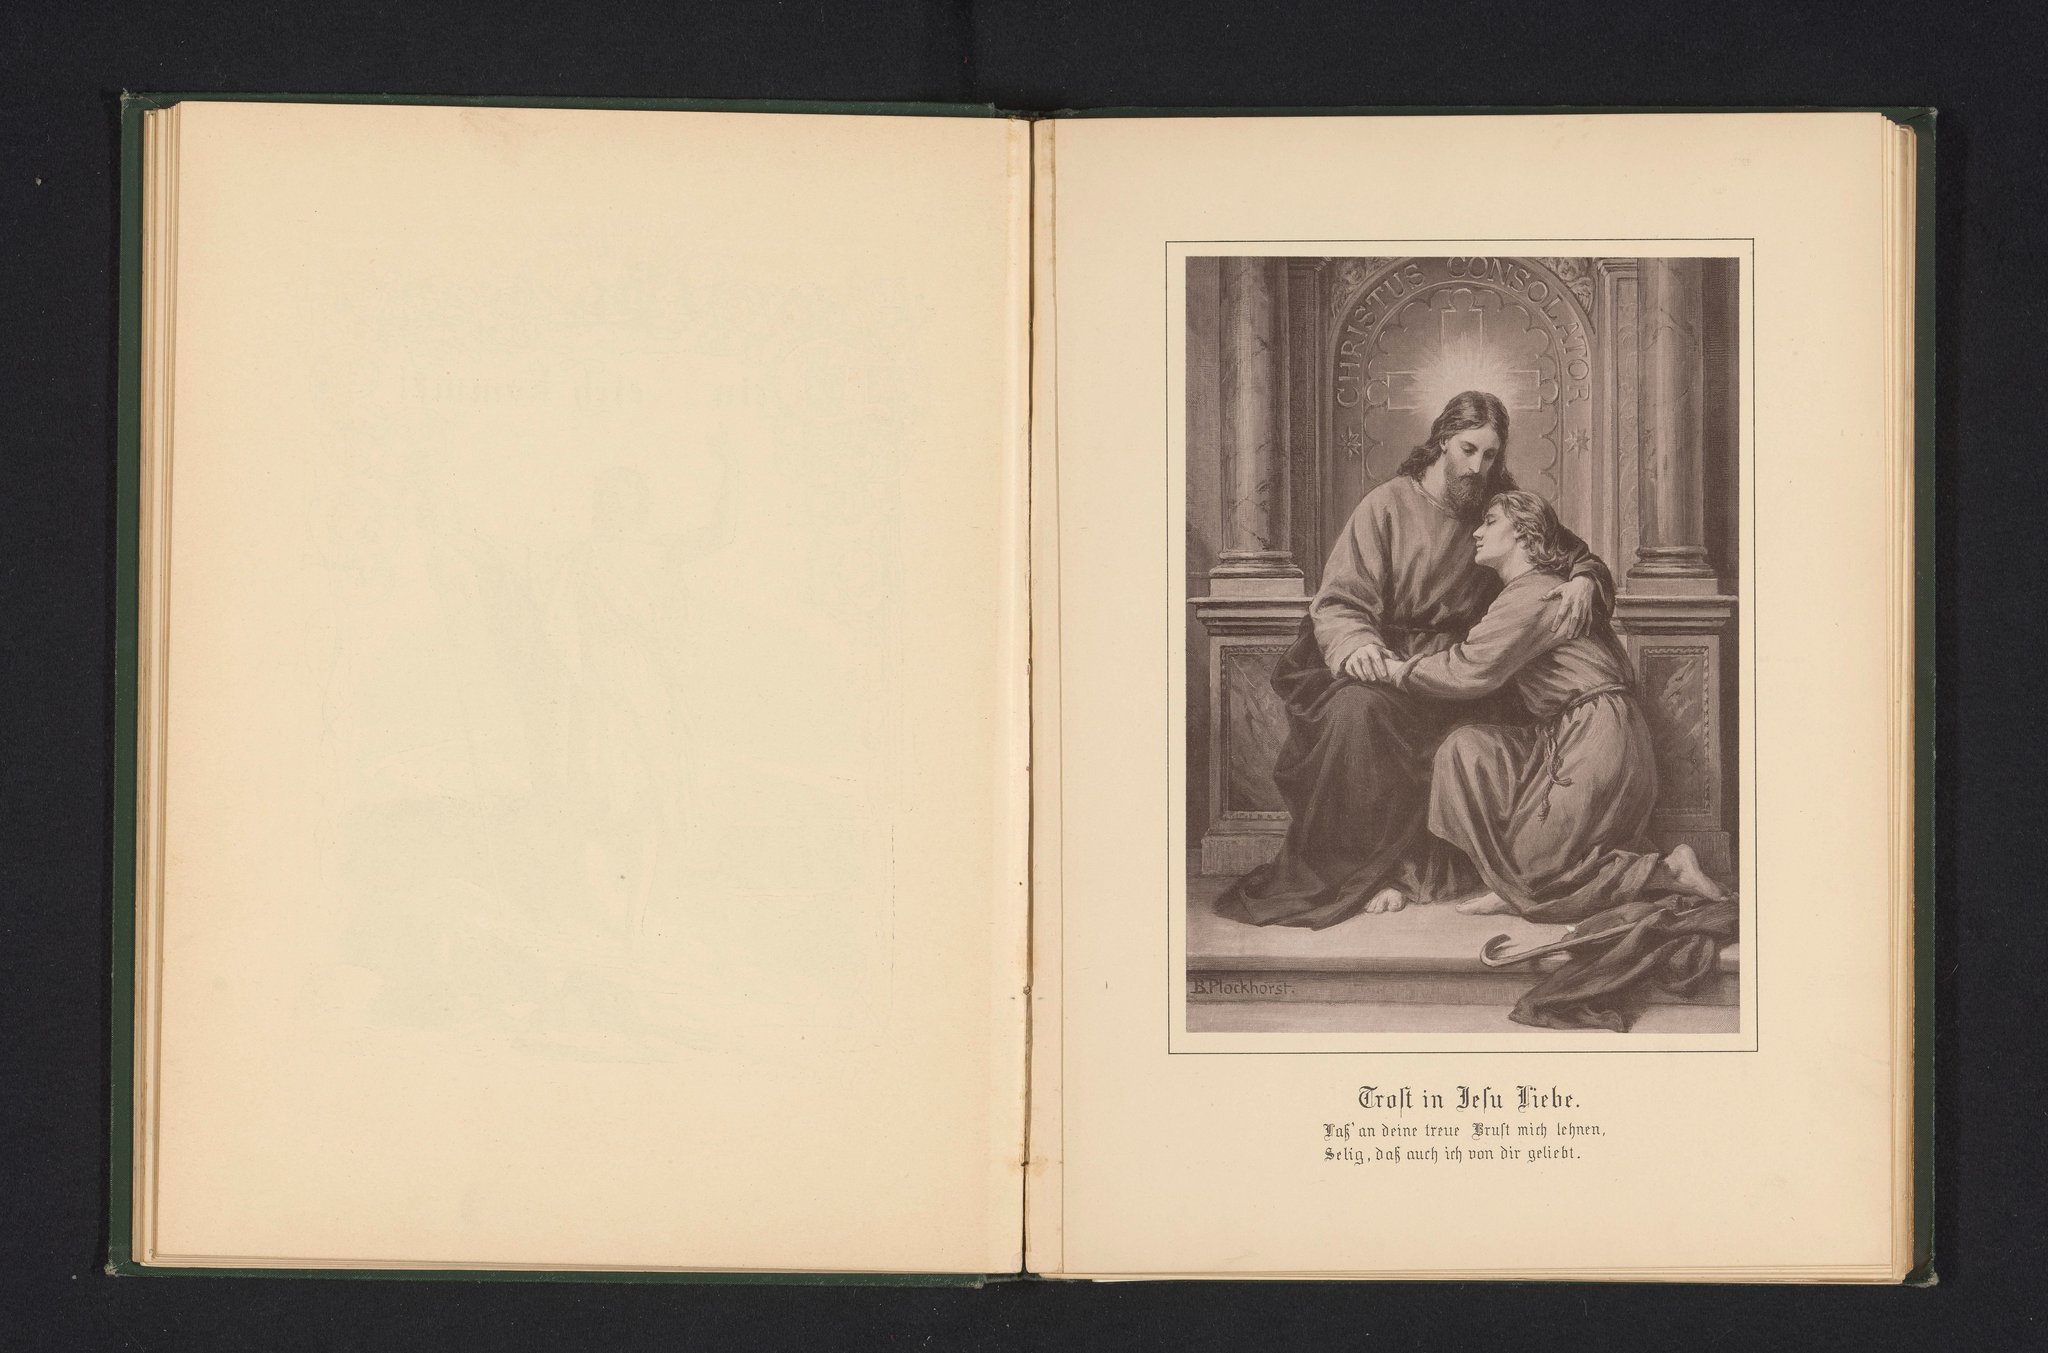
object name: page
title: Fotoreproductie van een schilderij van iemand die troost zoekt bij Christus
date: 1874-1884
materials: paper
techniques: photograph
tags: christ, monk(s), friar(s)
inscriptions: inscription: ‘[...]a[...]' an deine treue Brust mich lehnen, Selig, da[...] auch ich von dir geliebt.’